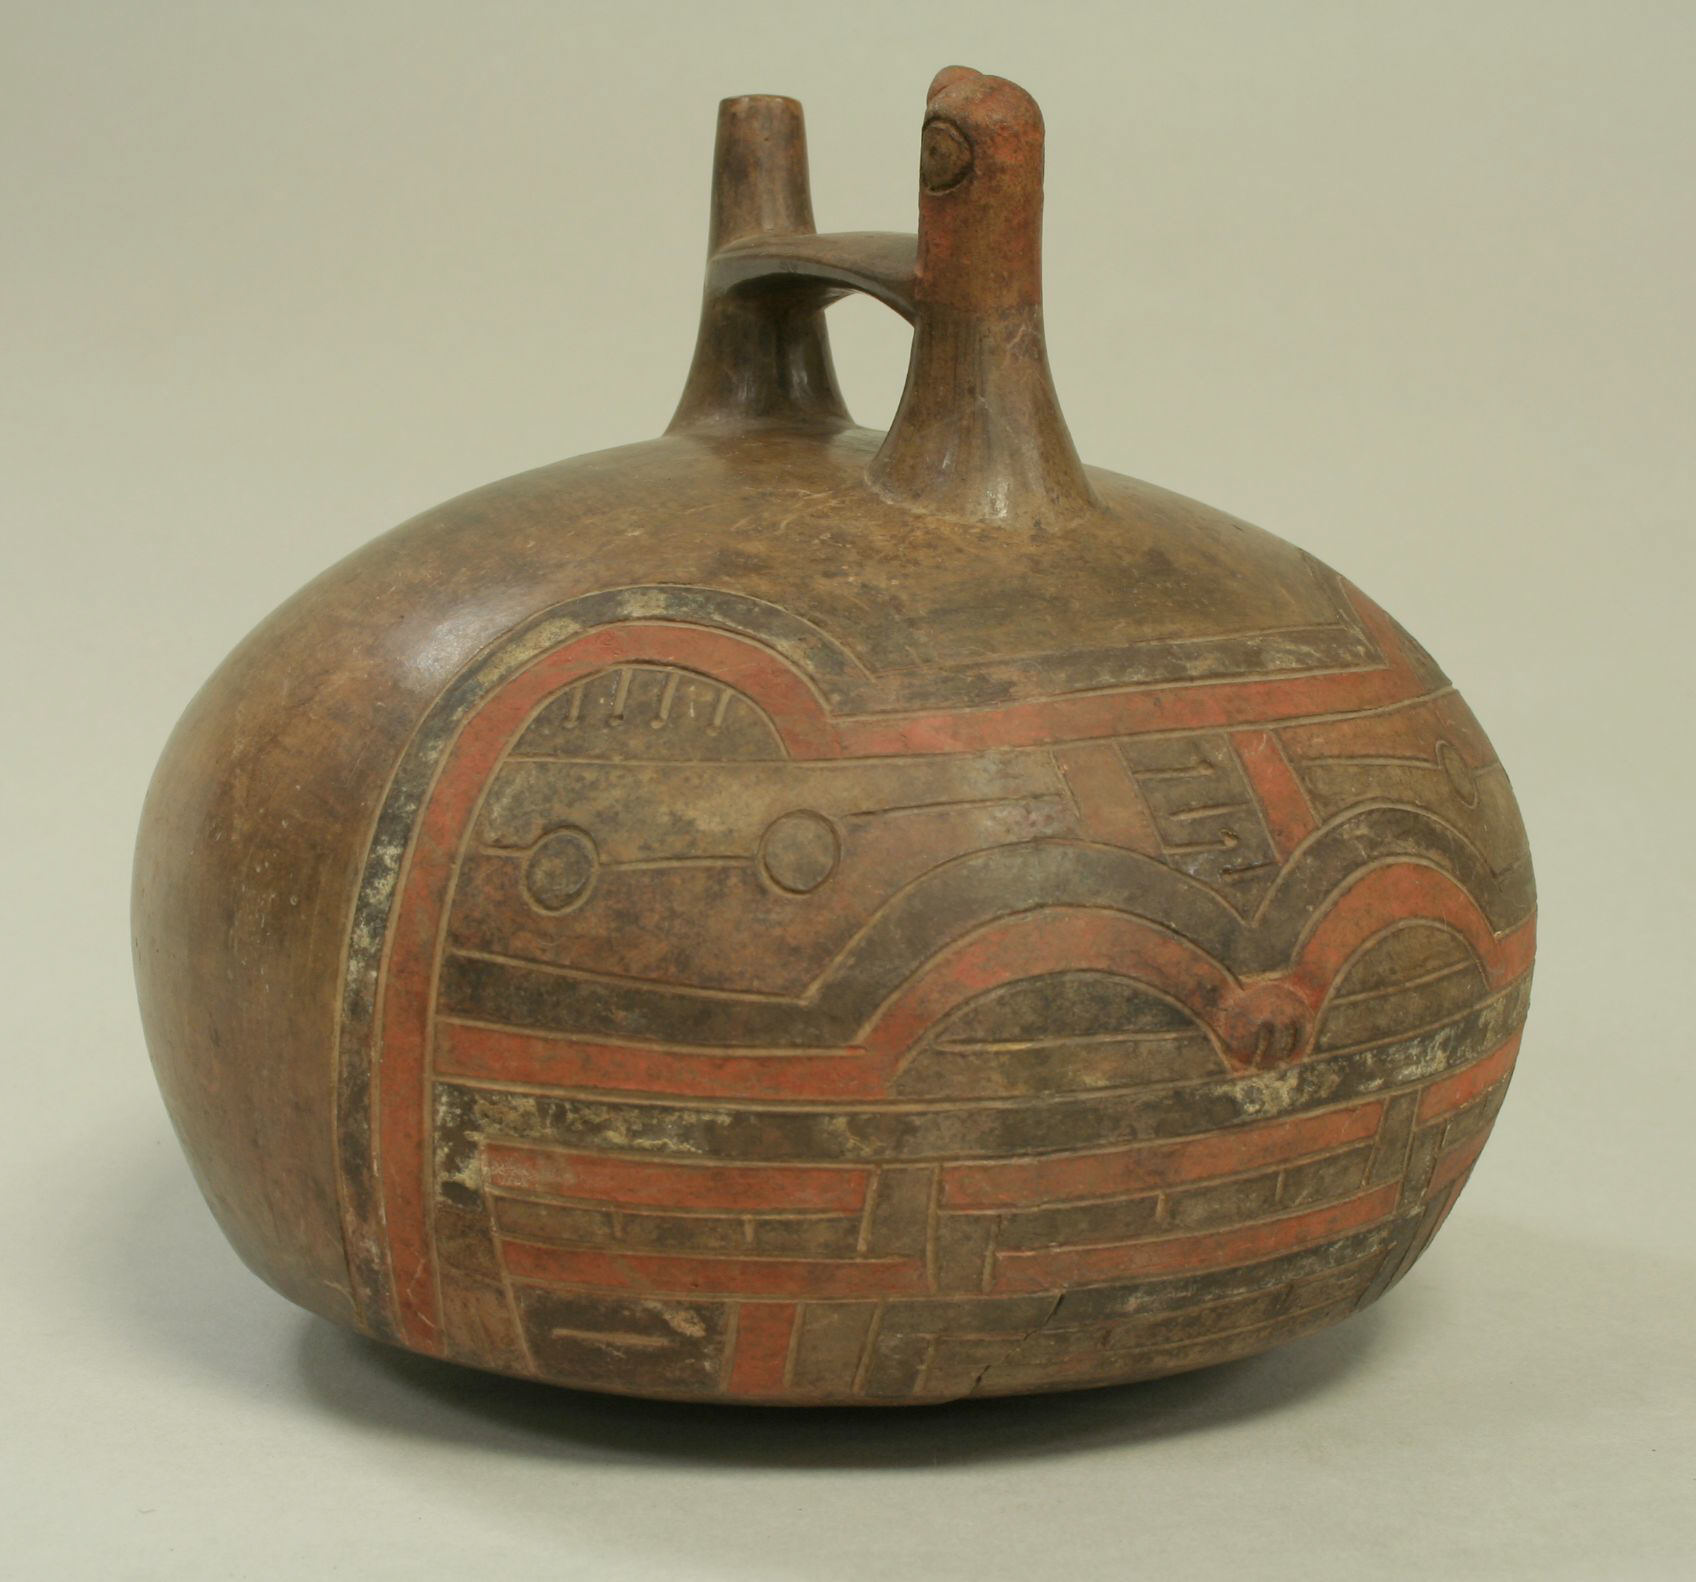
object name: bottle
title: Double Spout and Bridge Bottle with Feline and Bird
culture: paracas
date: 700-401 BCE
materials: ceramic, pigment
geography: peru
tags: birds